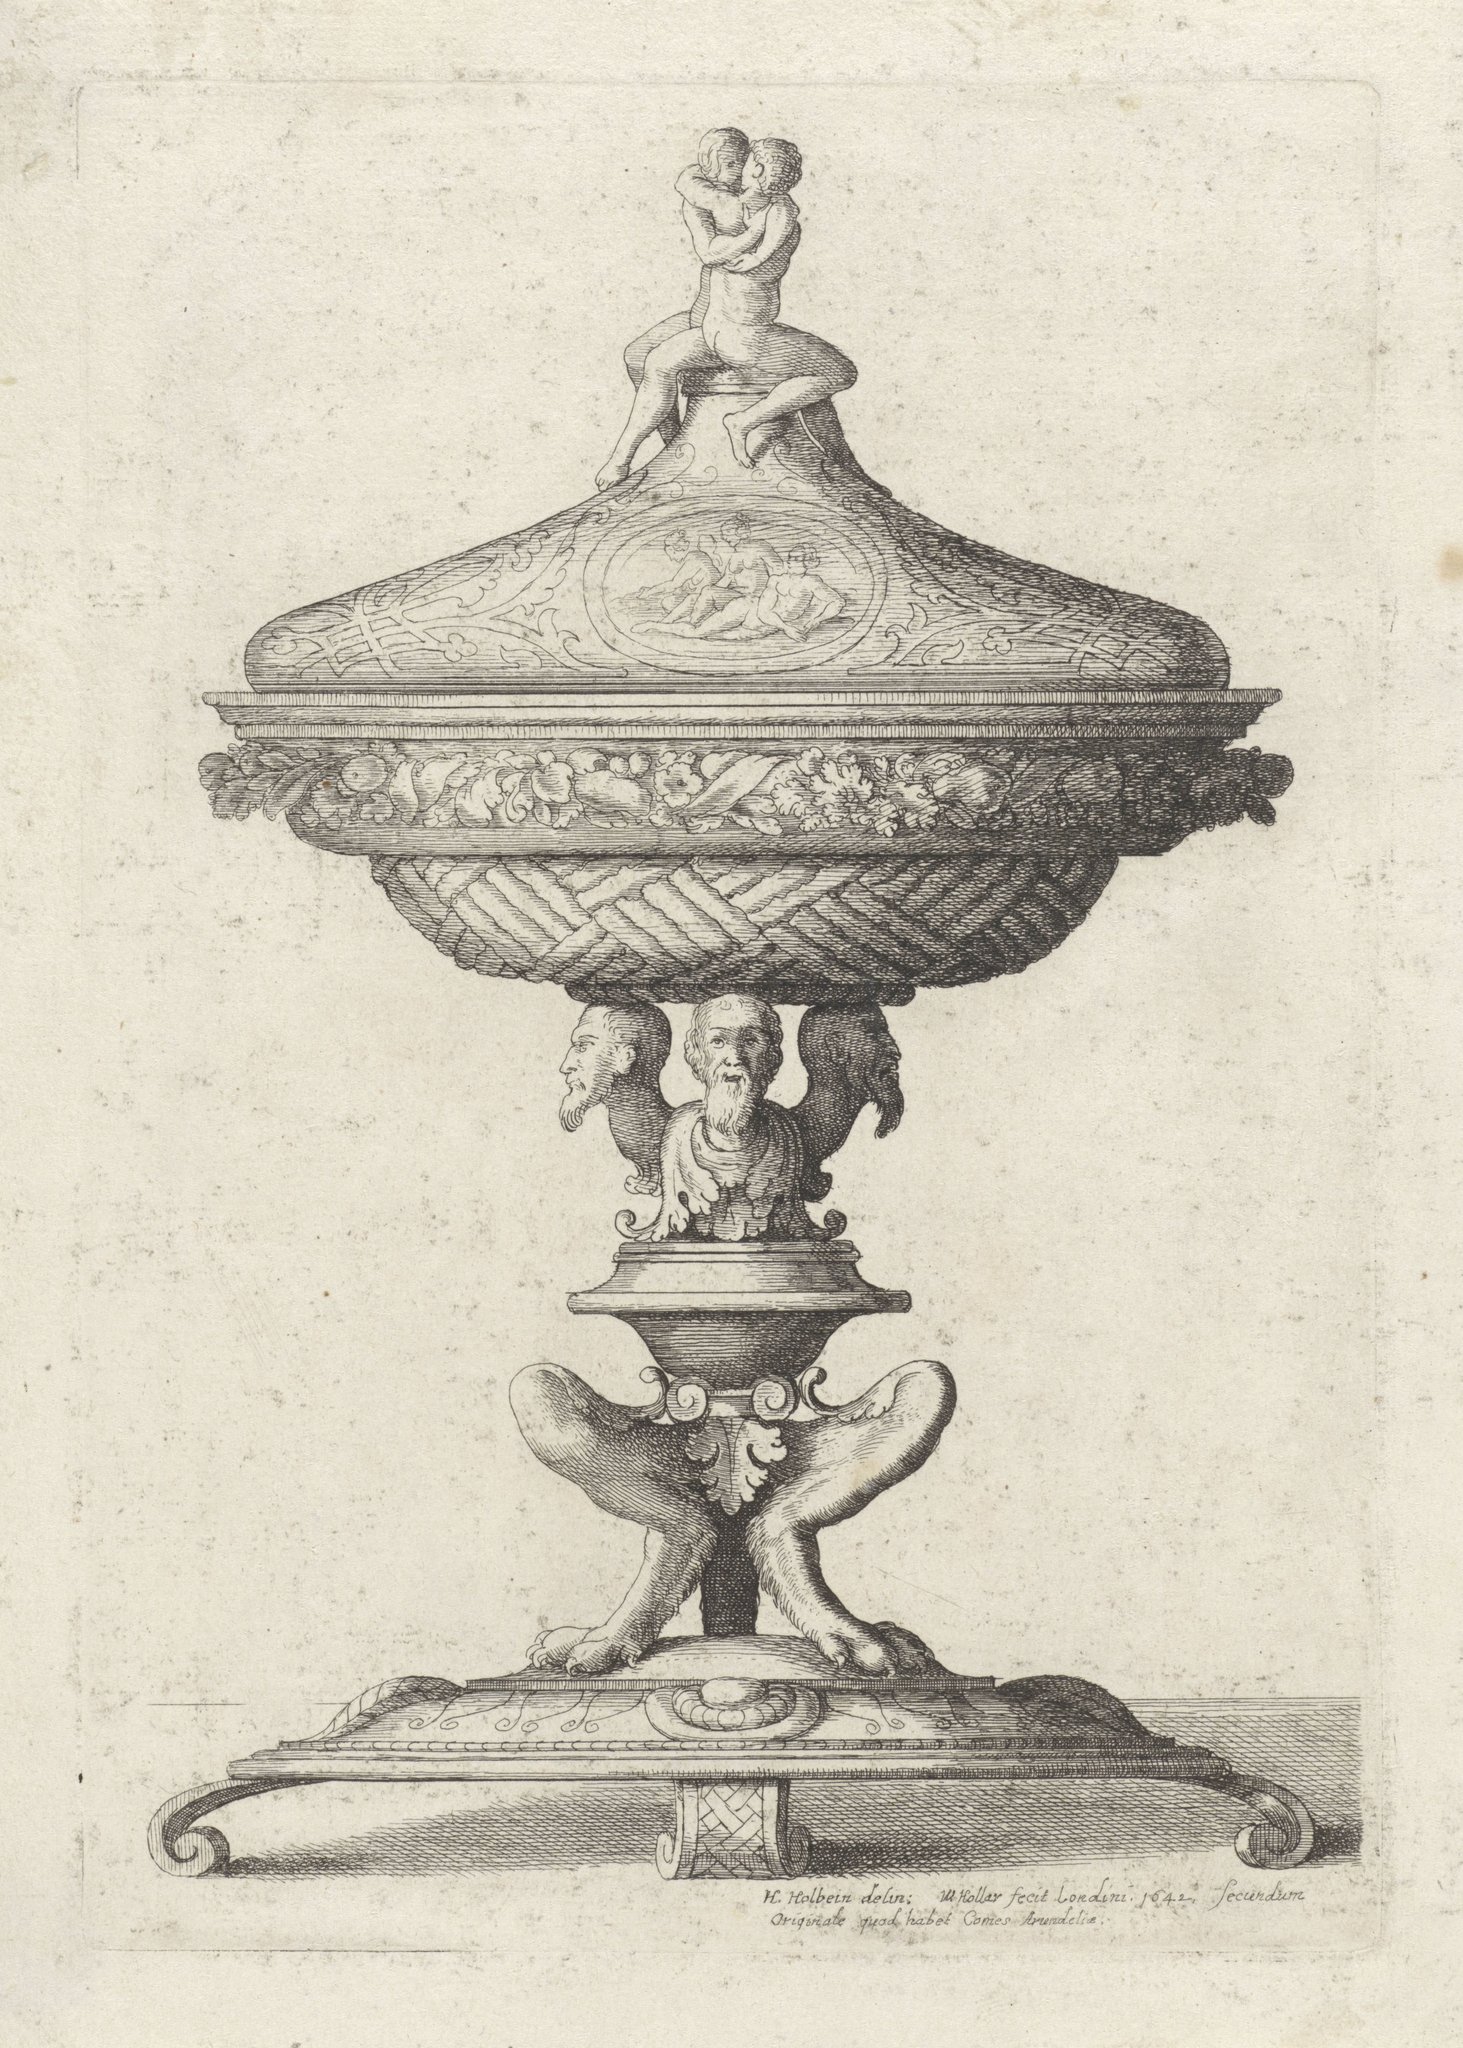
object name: print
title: Ornamentele bokaal met elkaar omhelzend paar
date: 1642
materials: paper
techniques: etching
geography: london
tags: embracing each other, kissing, laid table: table-ware, table-decoration, etc.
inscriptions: collector's mark: Lugt 4086, collector's mark: Lugt 2228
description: Ontwerp voor een ornamentele bokaal met een elkaar omhelzend paar.